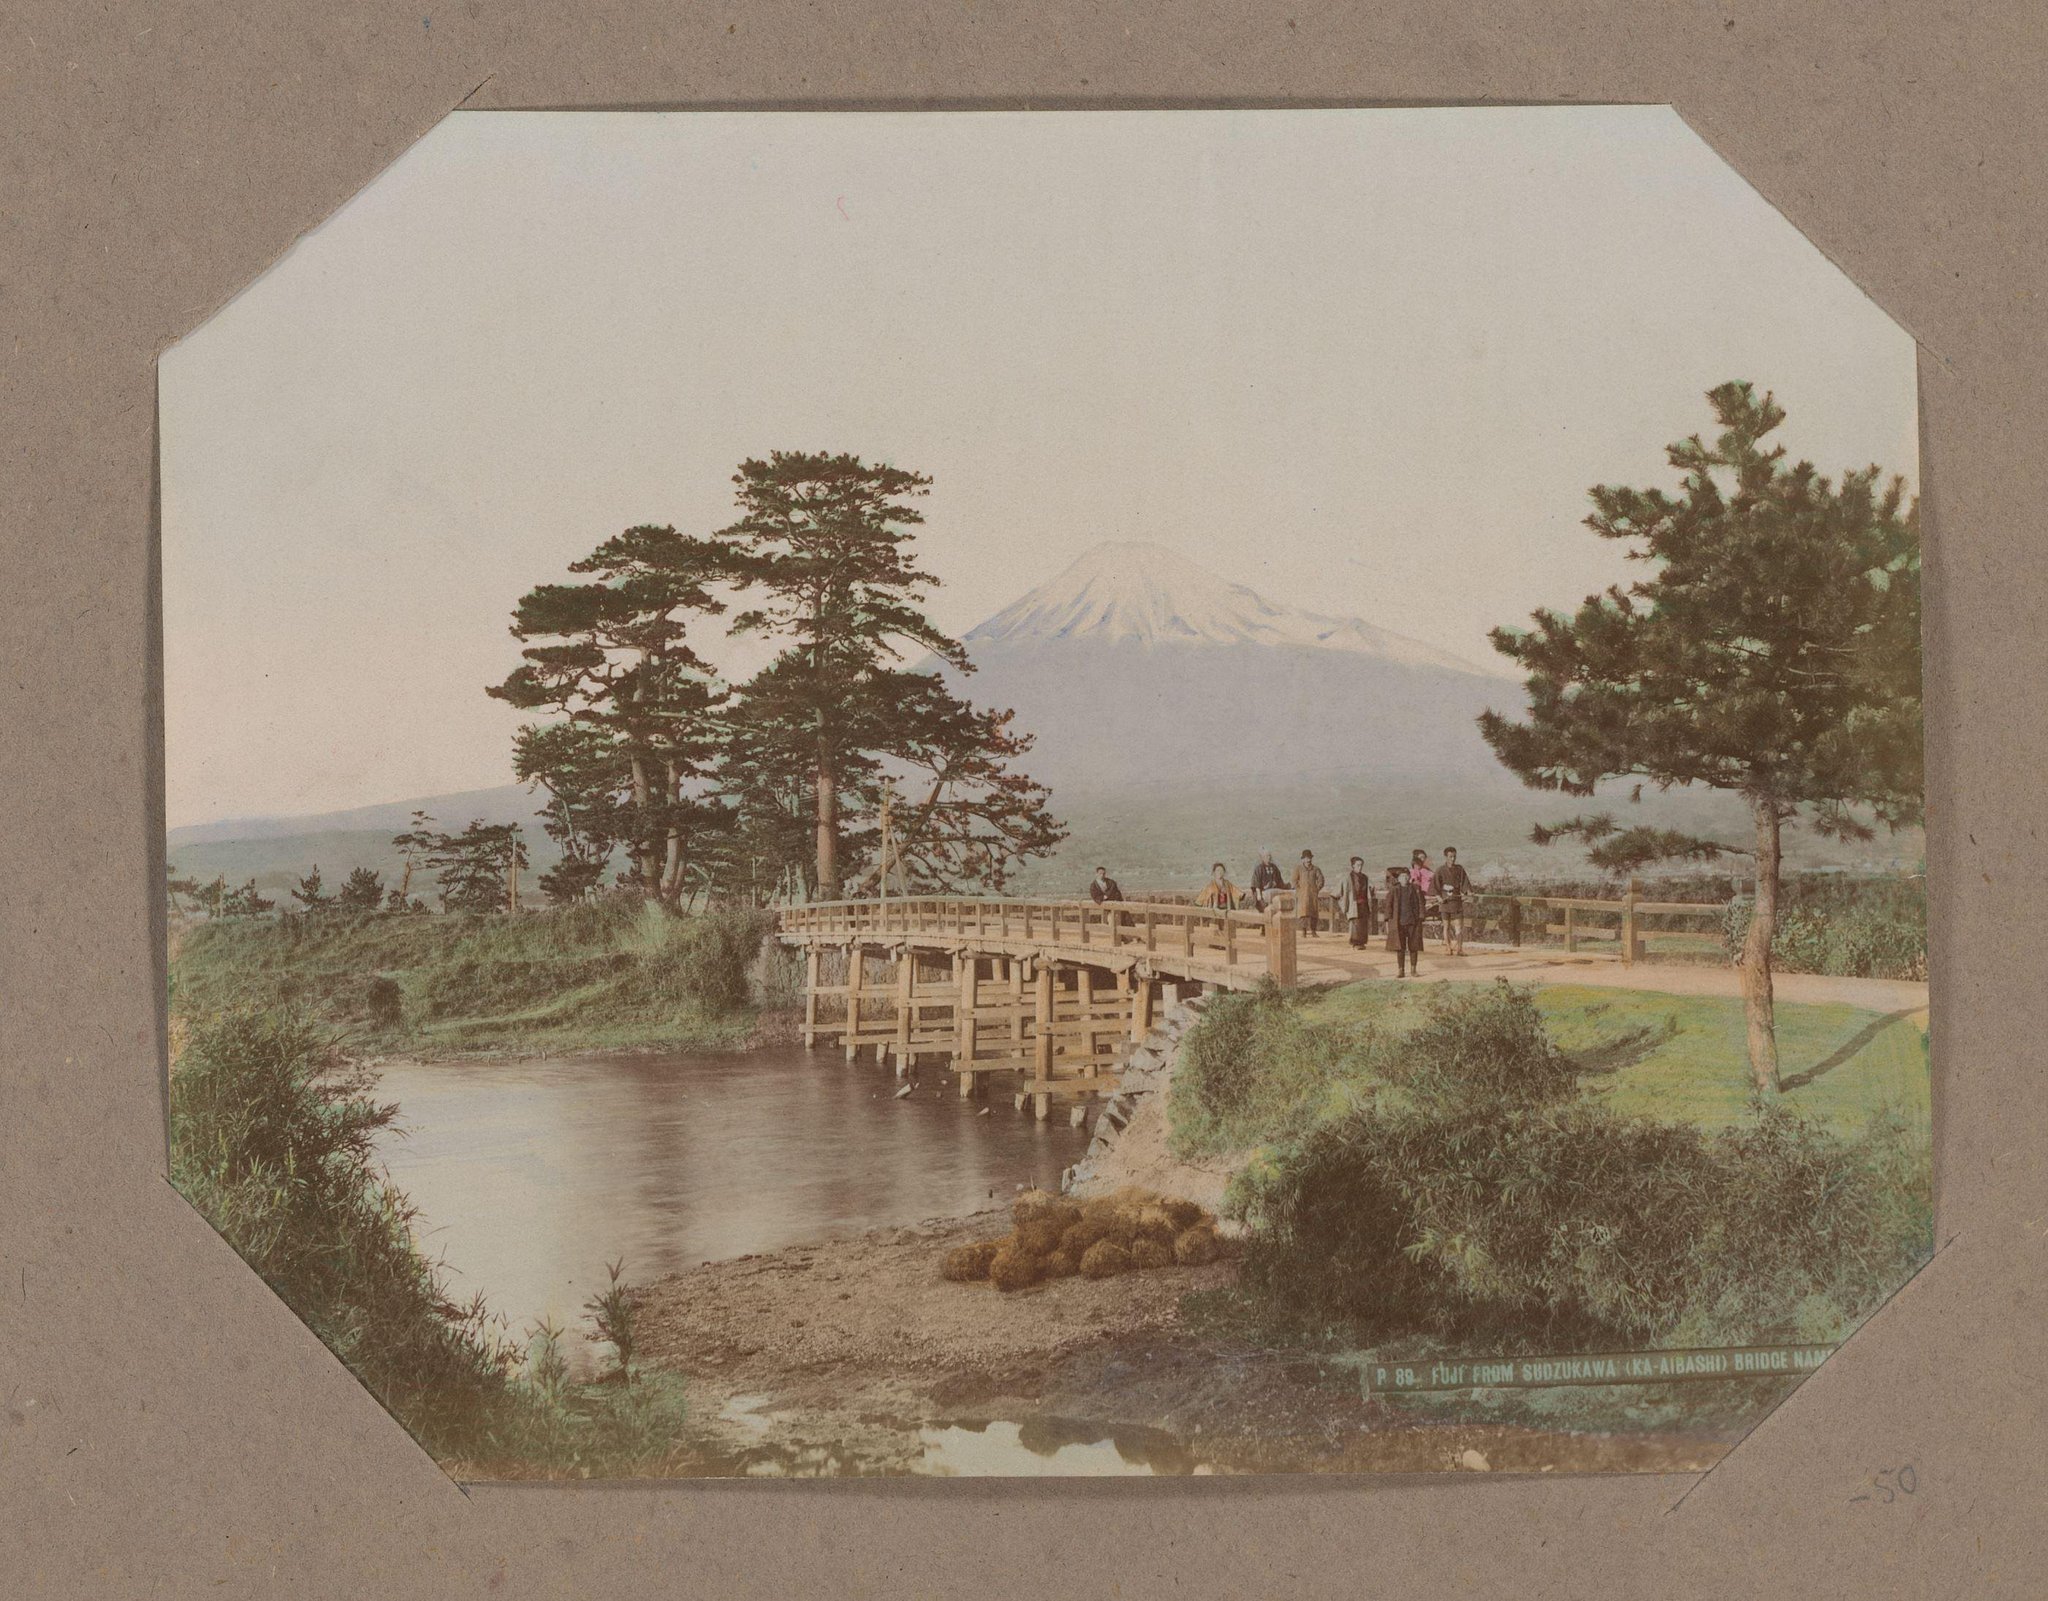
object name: album leaf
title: Gezicht op de Ka-Aibashi brug, met op de achtergrond de berg Fuji, Japan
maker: Anonymous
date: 1890-1903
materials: paper, photographic support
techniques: albumen print, hand coloring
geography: japan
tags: bridge, mountains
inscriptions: inscription: ‘P 89 Fuji from Sudsukawa (Ka-Aibashi) bridge name’